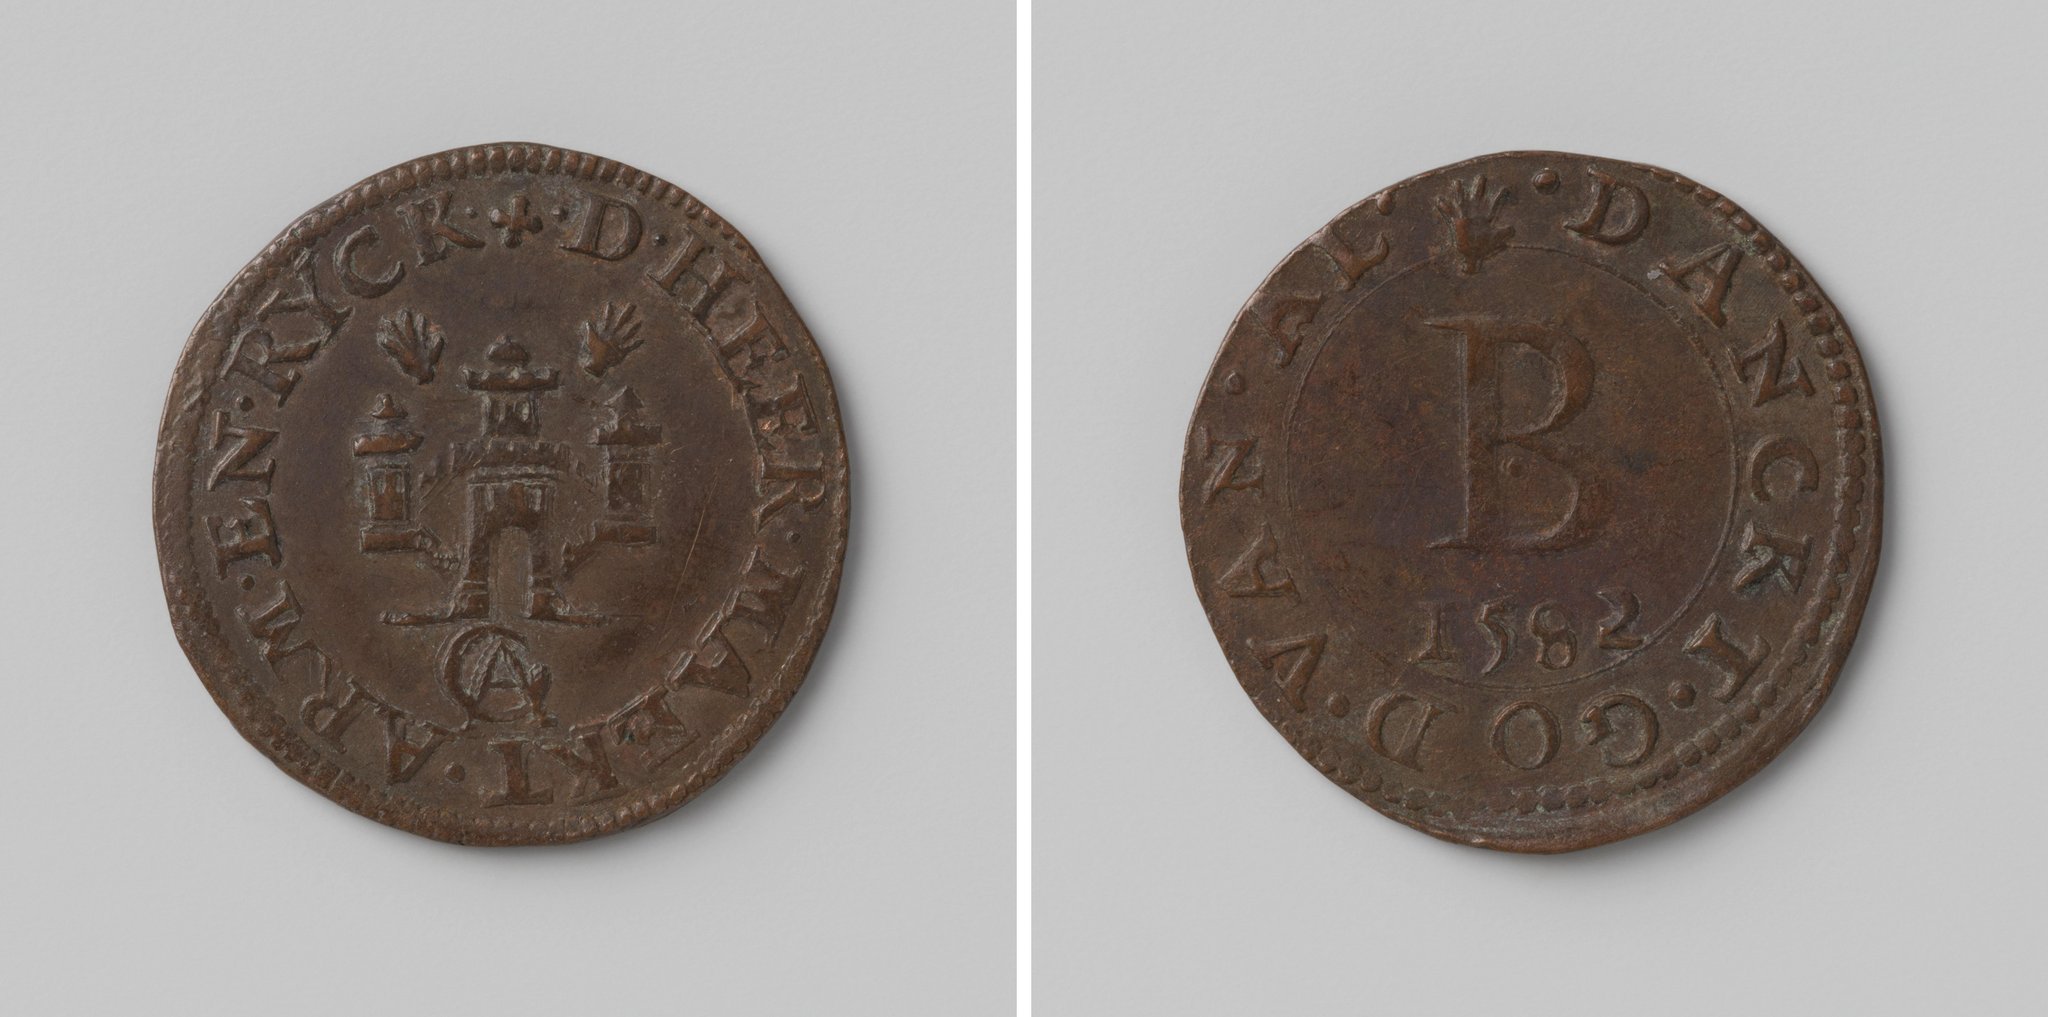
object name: armenloodje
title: Stad Antwerpen, loodje dat bij uitdeling recht gaf op brood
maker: Anonymous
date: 1582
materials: copper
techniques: striking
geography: antwerp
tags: antwerp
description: Koperen penning. Voorzijde: twee geopende handen boven burcht en monogram van letters C en A binnen omschrift. Keerzijde: letter B boven jaartal binnen omschrift